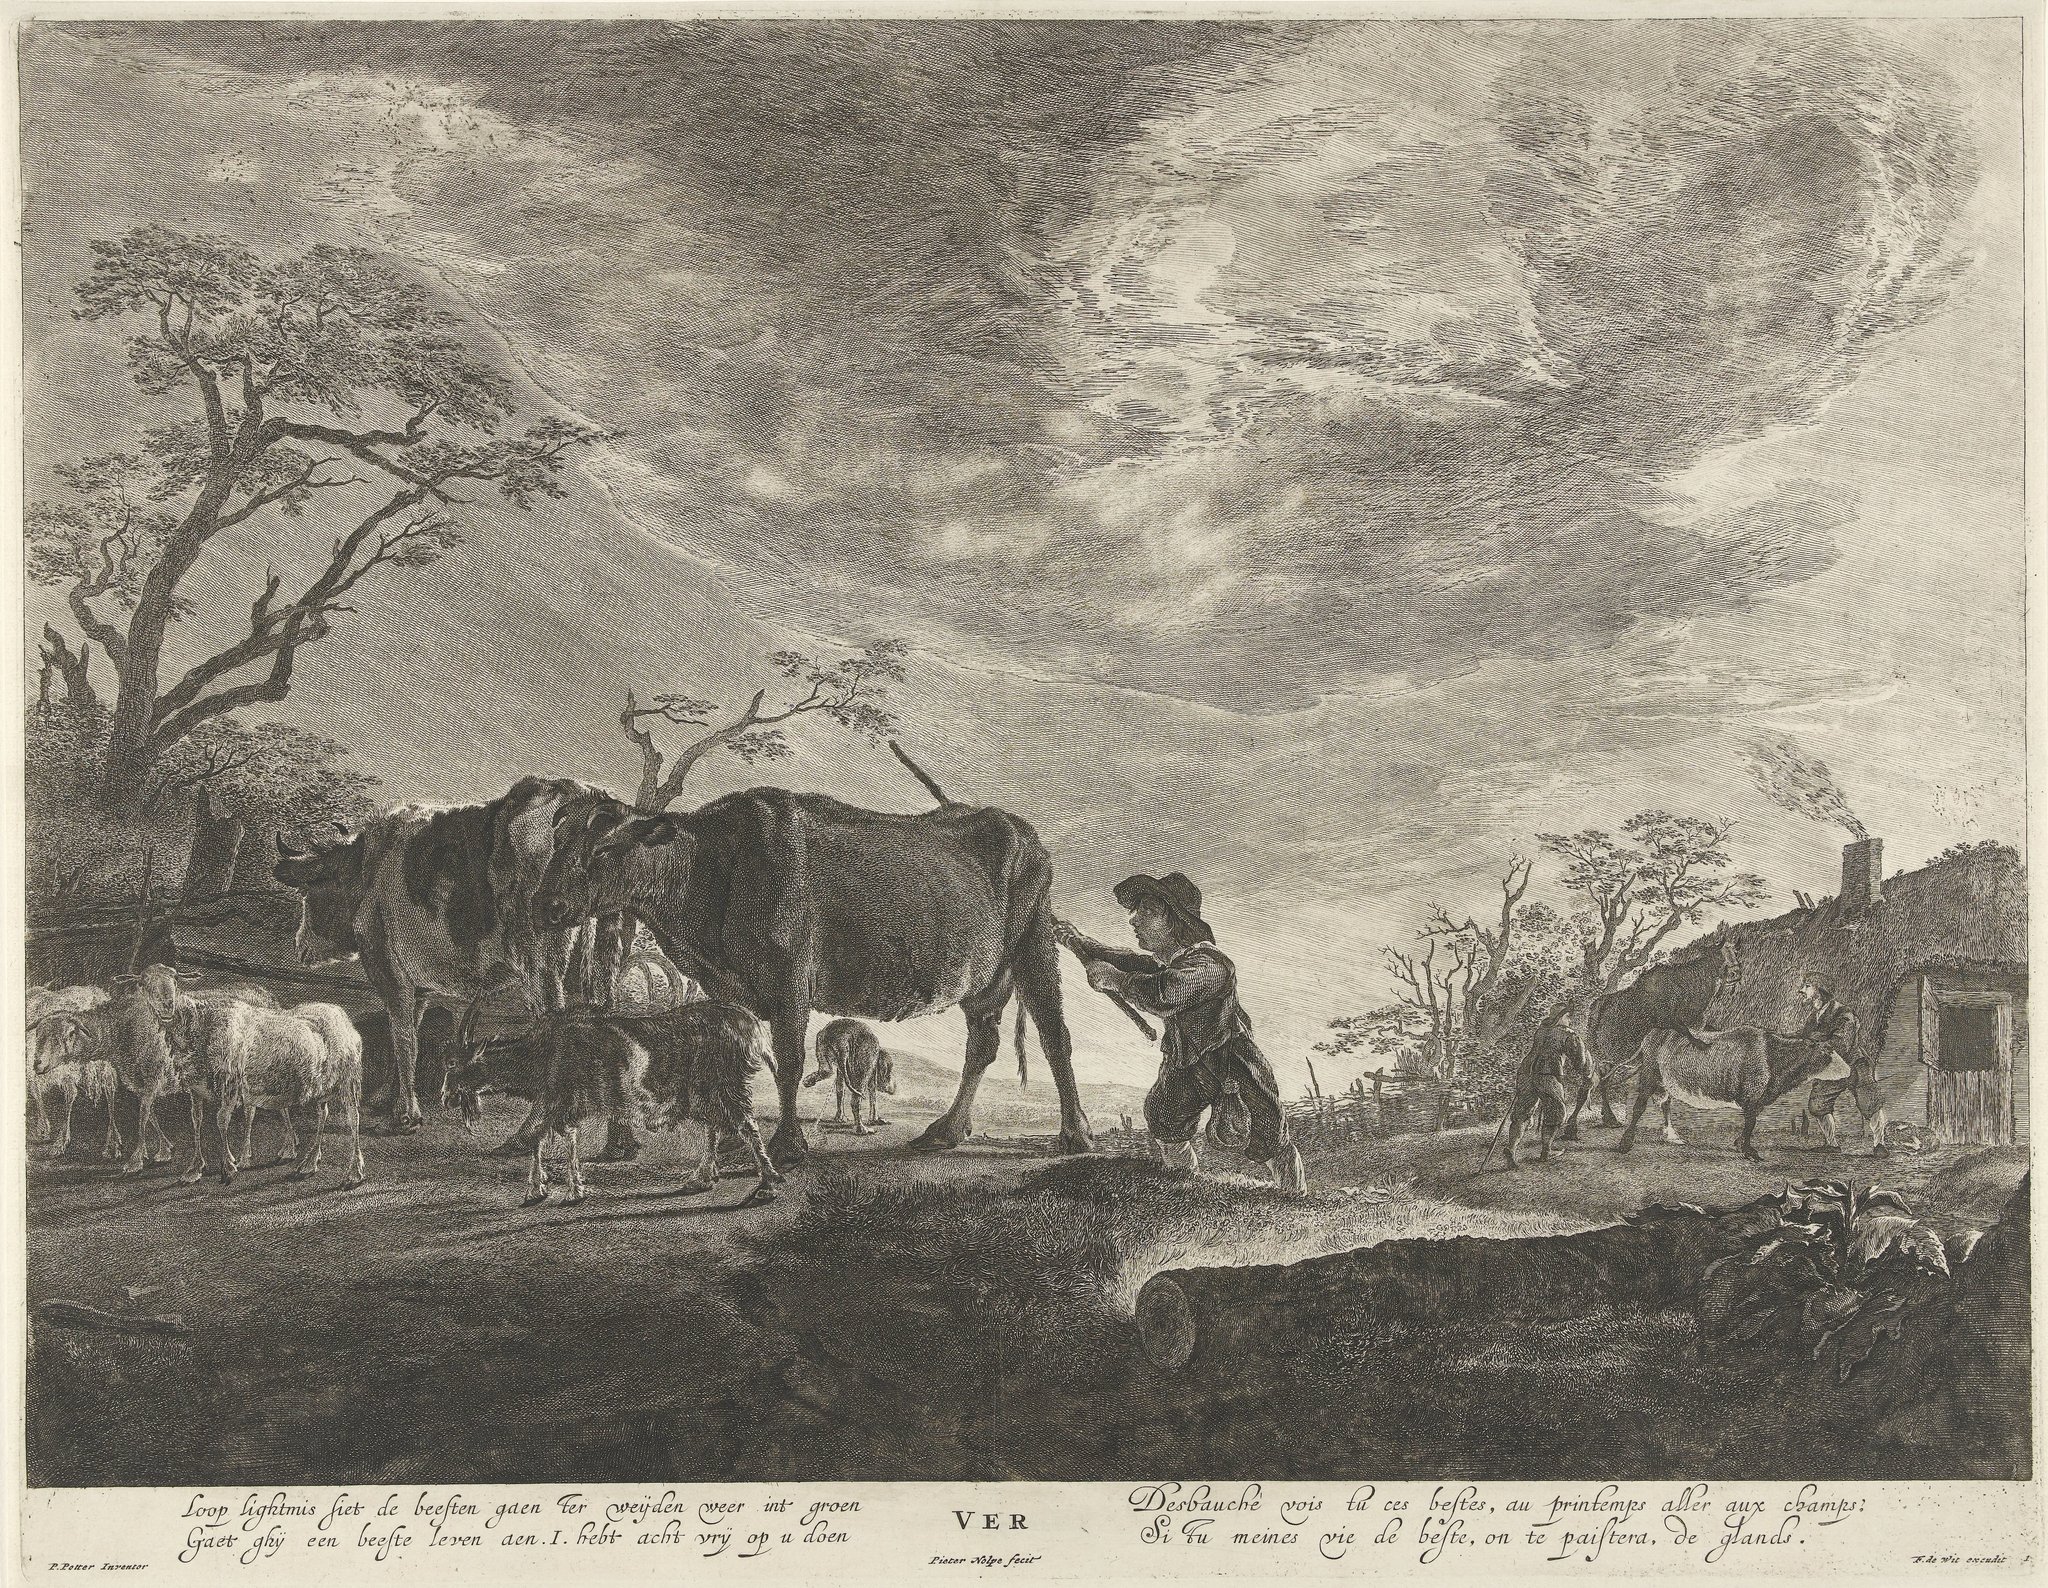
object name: print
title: Landschap met een veedrijver: het seizoen lente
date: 1640-1706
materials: paper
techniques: engraving, etching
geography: amsterdam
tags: landscape symbolizing april, cow, cattle driving, cattle driver, goat, spring landscape; landscape symbolizing spring (the four seasons of the year)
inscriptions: collector's mark: Lugt 2228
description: Landschap met een veedrijver met een kudde koeien en geiten. Rechts voor een boerderij bestijgt een stier een koe. Twee mannen staan daarnaast. Onderaan in de marge een tweeregelig vers in het Nederlands en een tweeregelig vers in het Frans. Nr. 1 uit een serie van verschillende maanden, die eveneens een element of seizoen verbeelden.